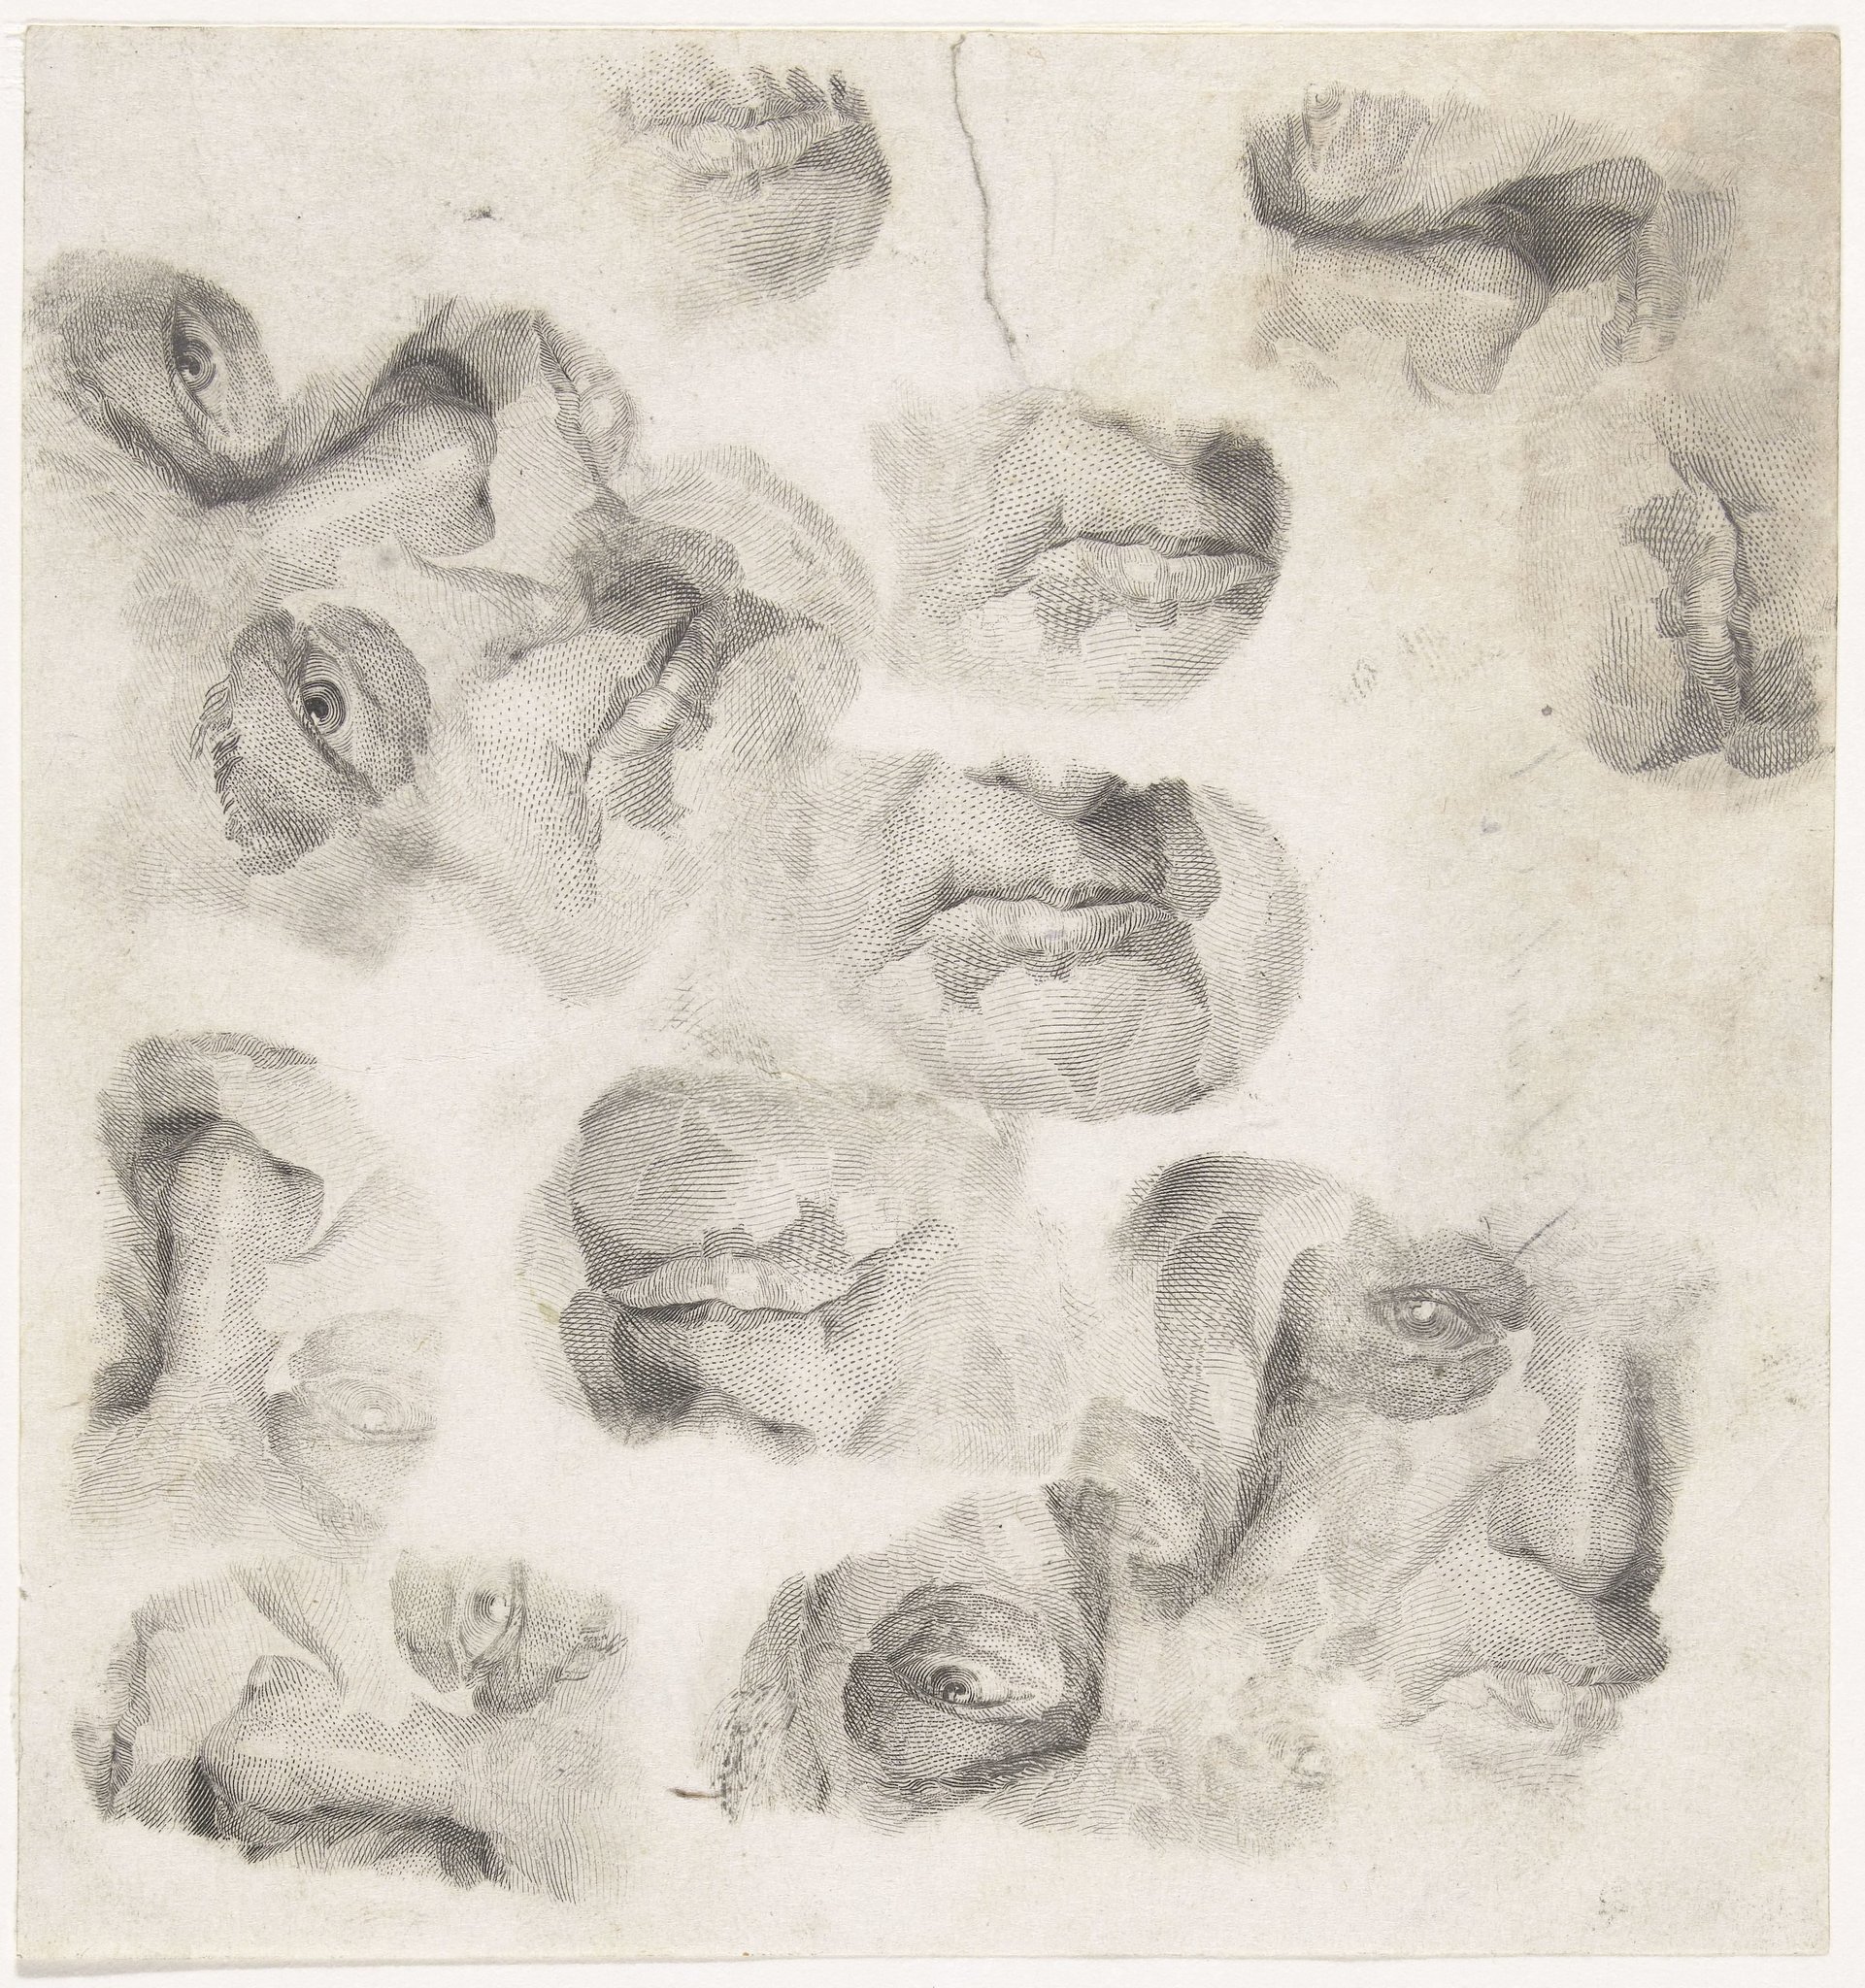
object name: print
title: Graveeroefeningen: monden en ogen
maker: henricus wilhelmus couwenberg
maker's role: draughtsman, print maker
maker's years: 1814-1845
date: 1829-1845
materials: paper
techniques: engraving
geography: amsterdam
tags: eyes, mouth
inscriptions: name: ‘J.J. van der A...’